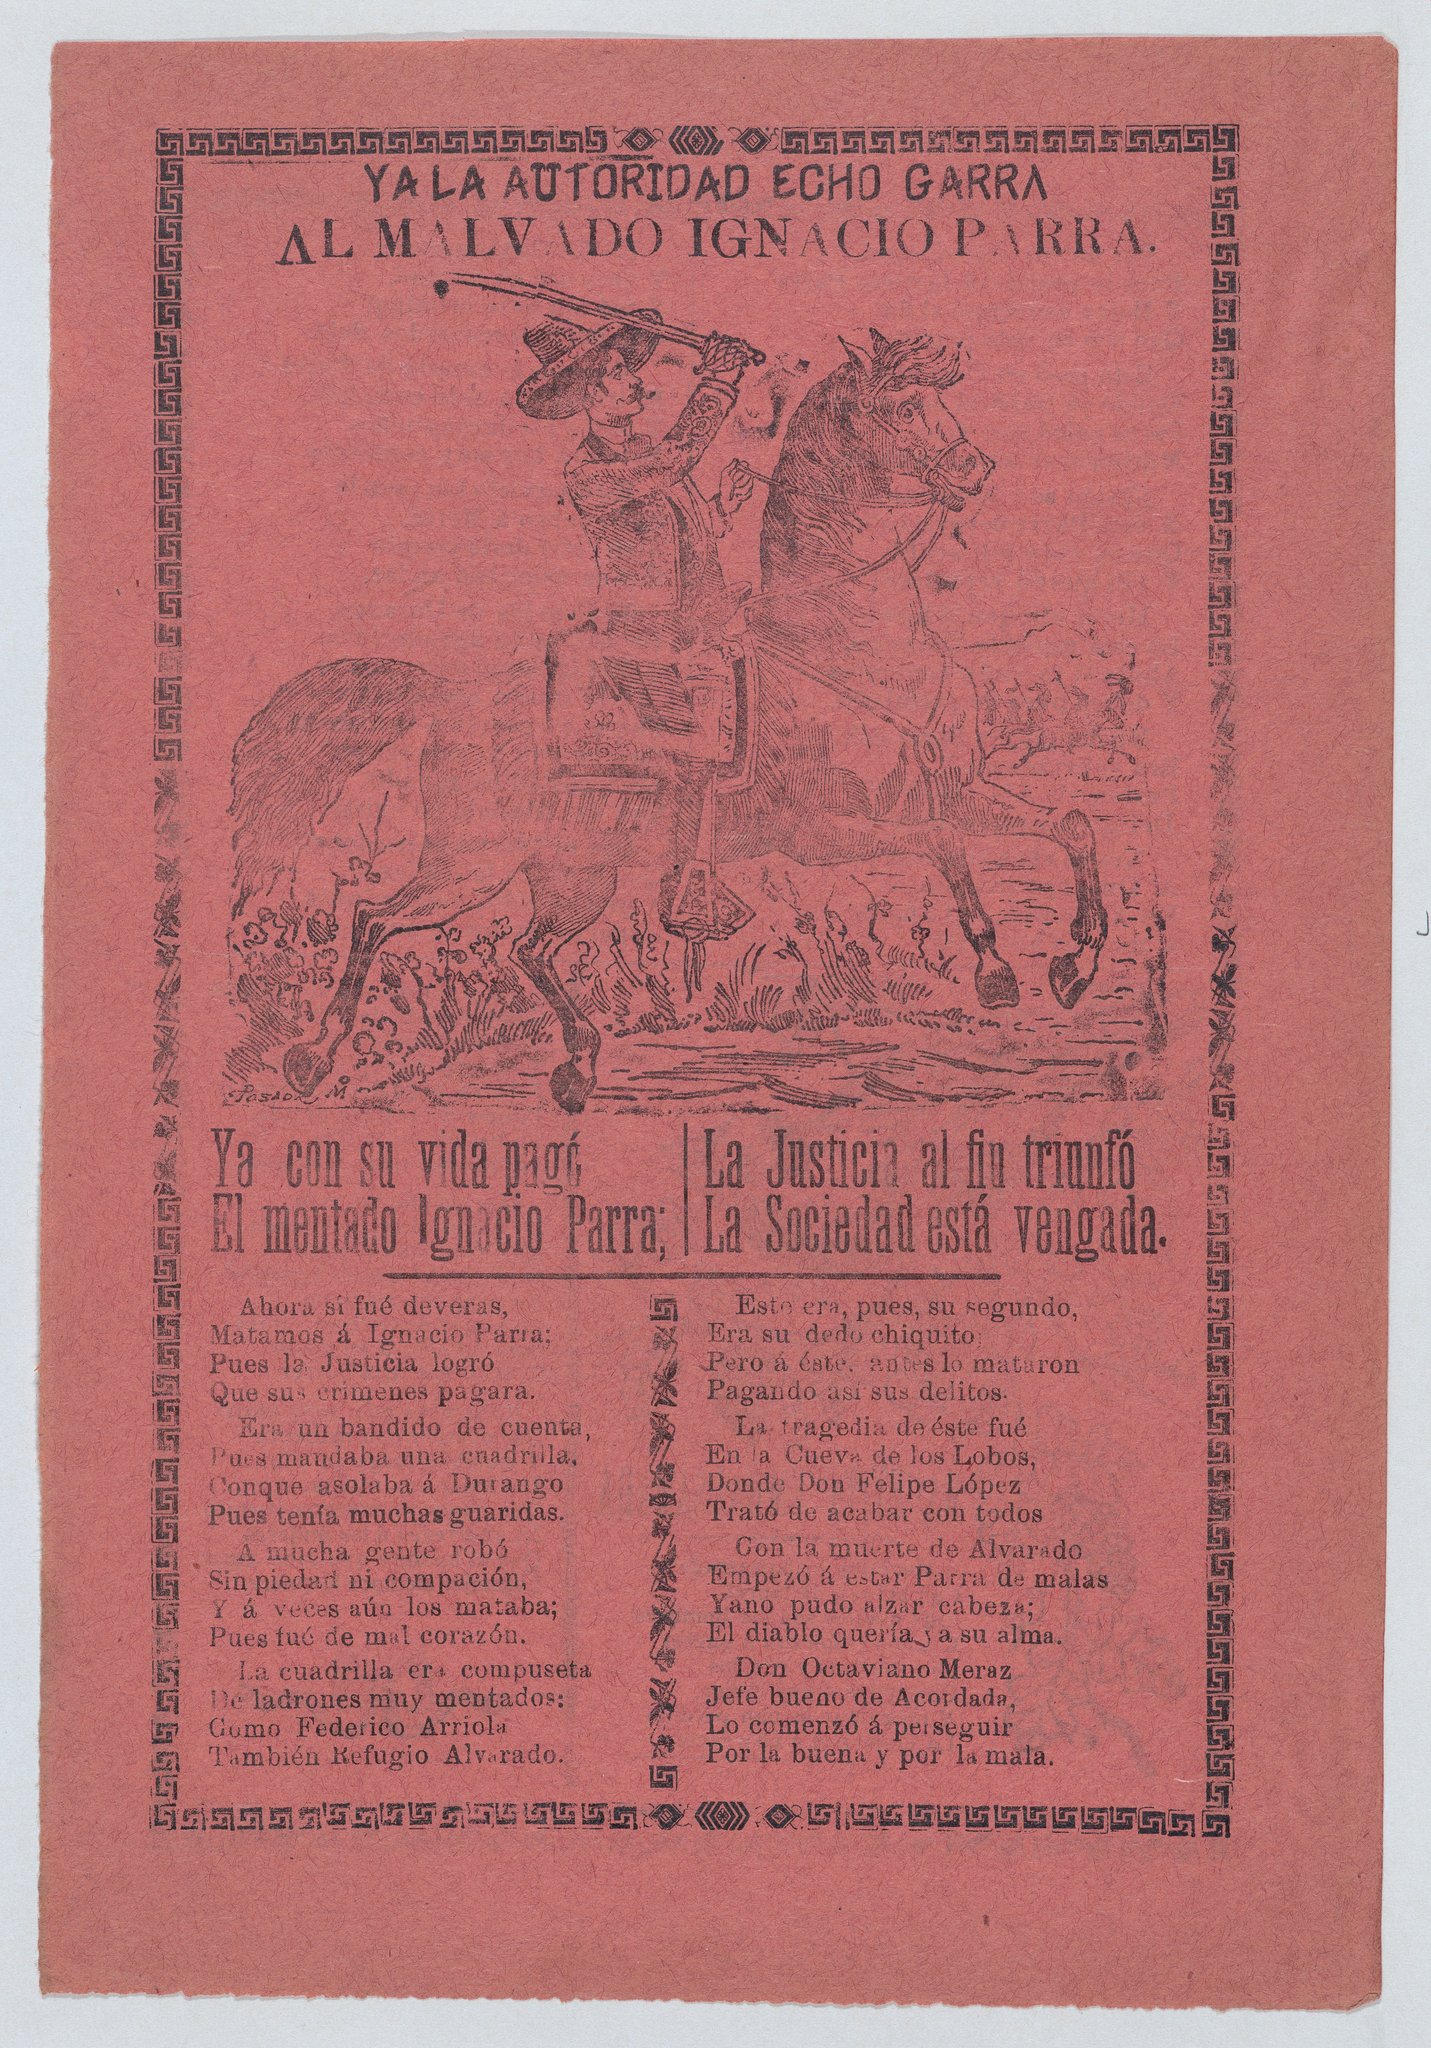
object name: print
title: Broadsheet about a thief named Malvado Ignacio Parra, who is shown on horseback holding a sword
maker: josé guadalupe posada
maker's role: artist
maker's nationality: mexican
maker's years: 1852-1913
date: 1900-1913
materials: paper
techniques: letterpress, lithography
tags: swords,men,horses